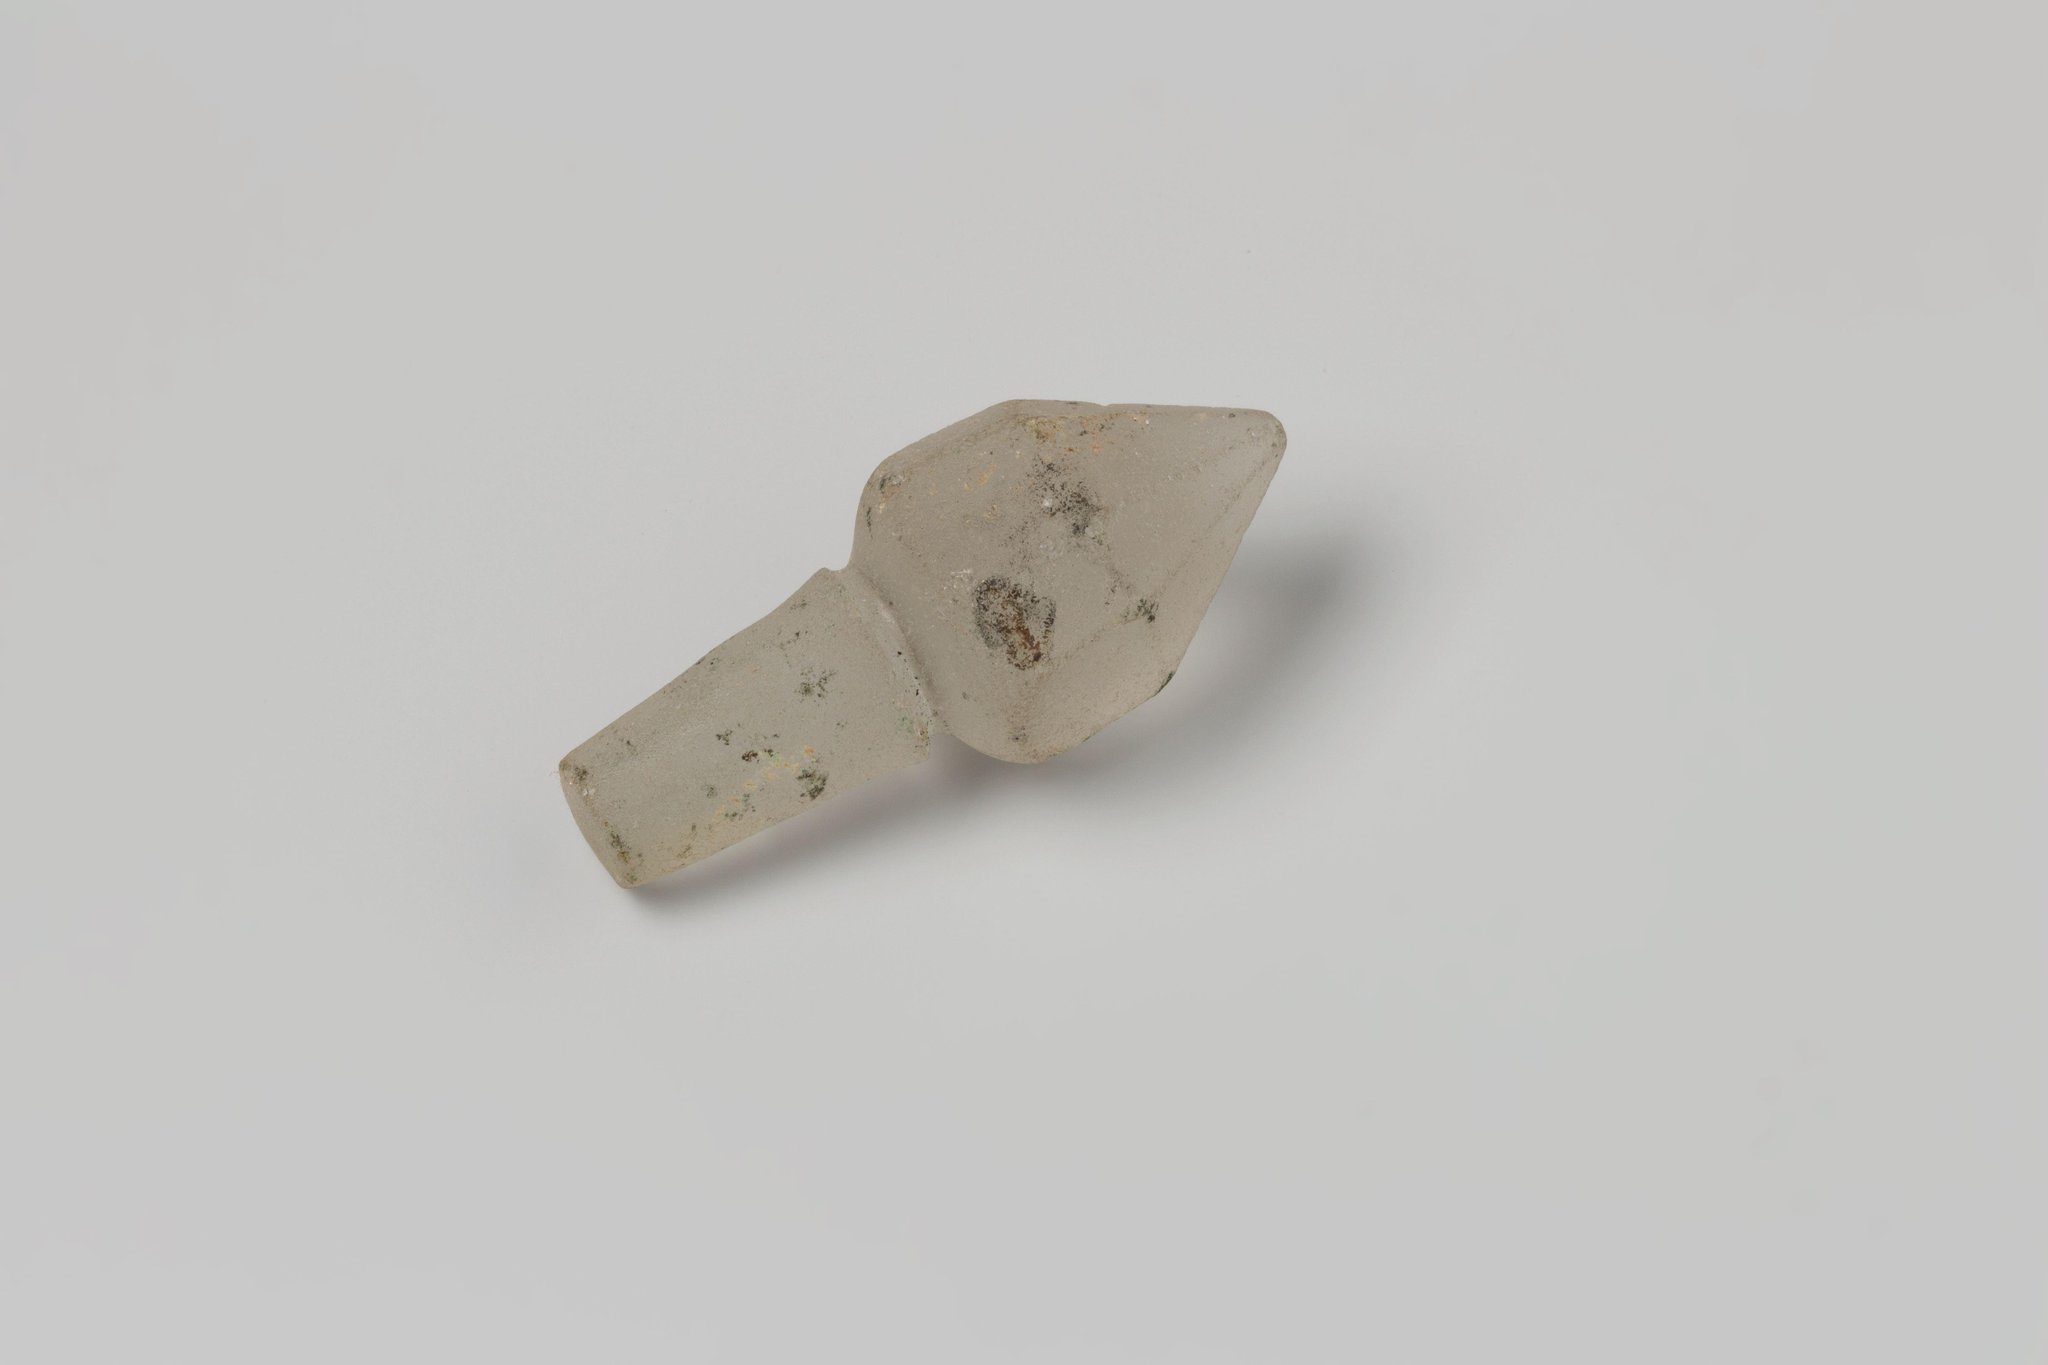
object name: vessel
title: Stop van vaatwerk uit het wrak van de Oost-Indiëvaarder Hollandia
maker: Anonymous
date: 1700-1743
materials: glass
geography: netherlands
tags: verenigde oostindische compagnie, hollandia (schip), annet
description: Vessel part, stopper; tapering cylinder with octagonal faceted conical (steeple-shaped) finial.